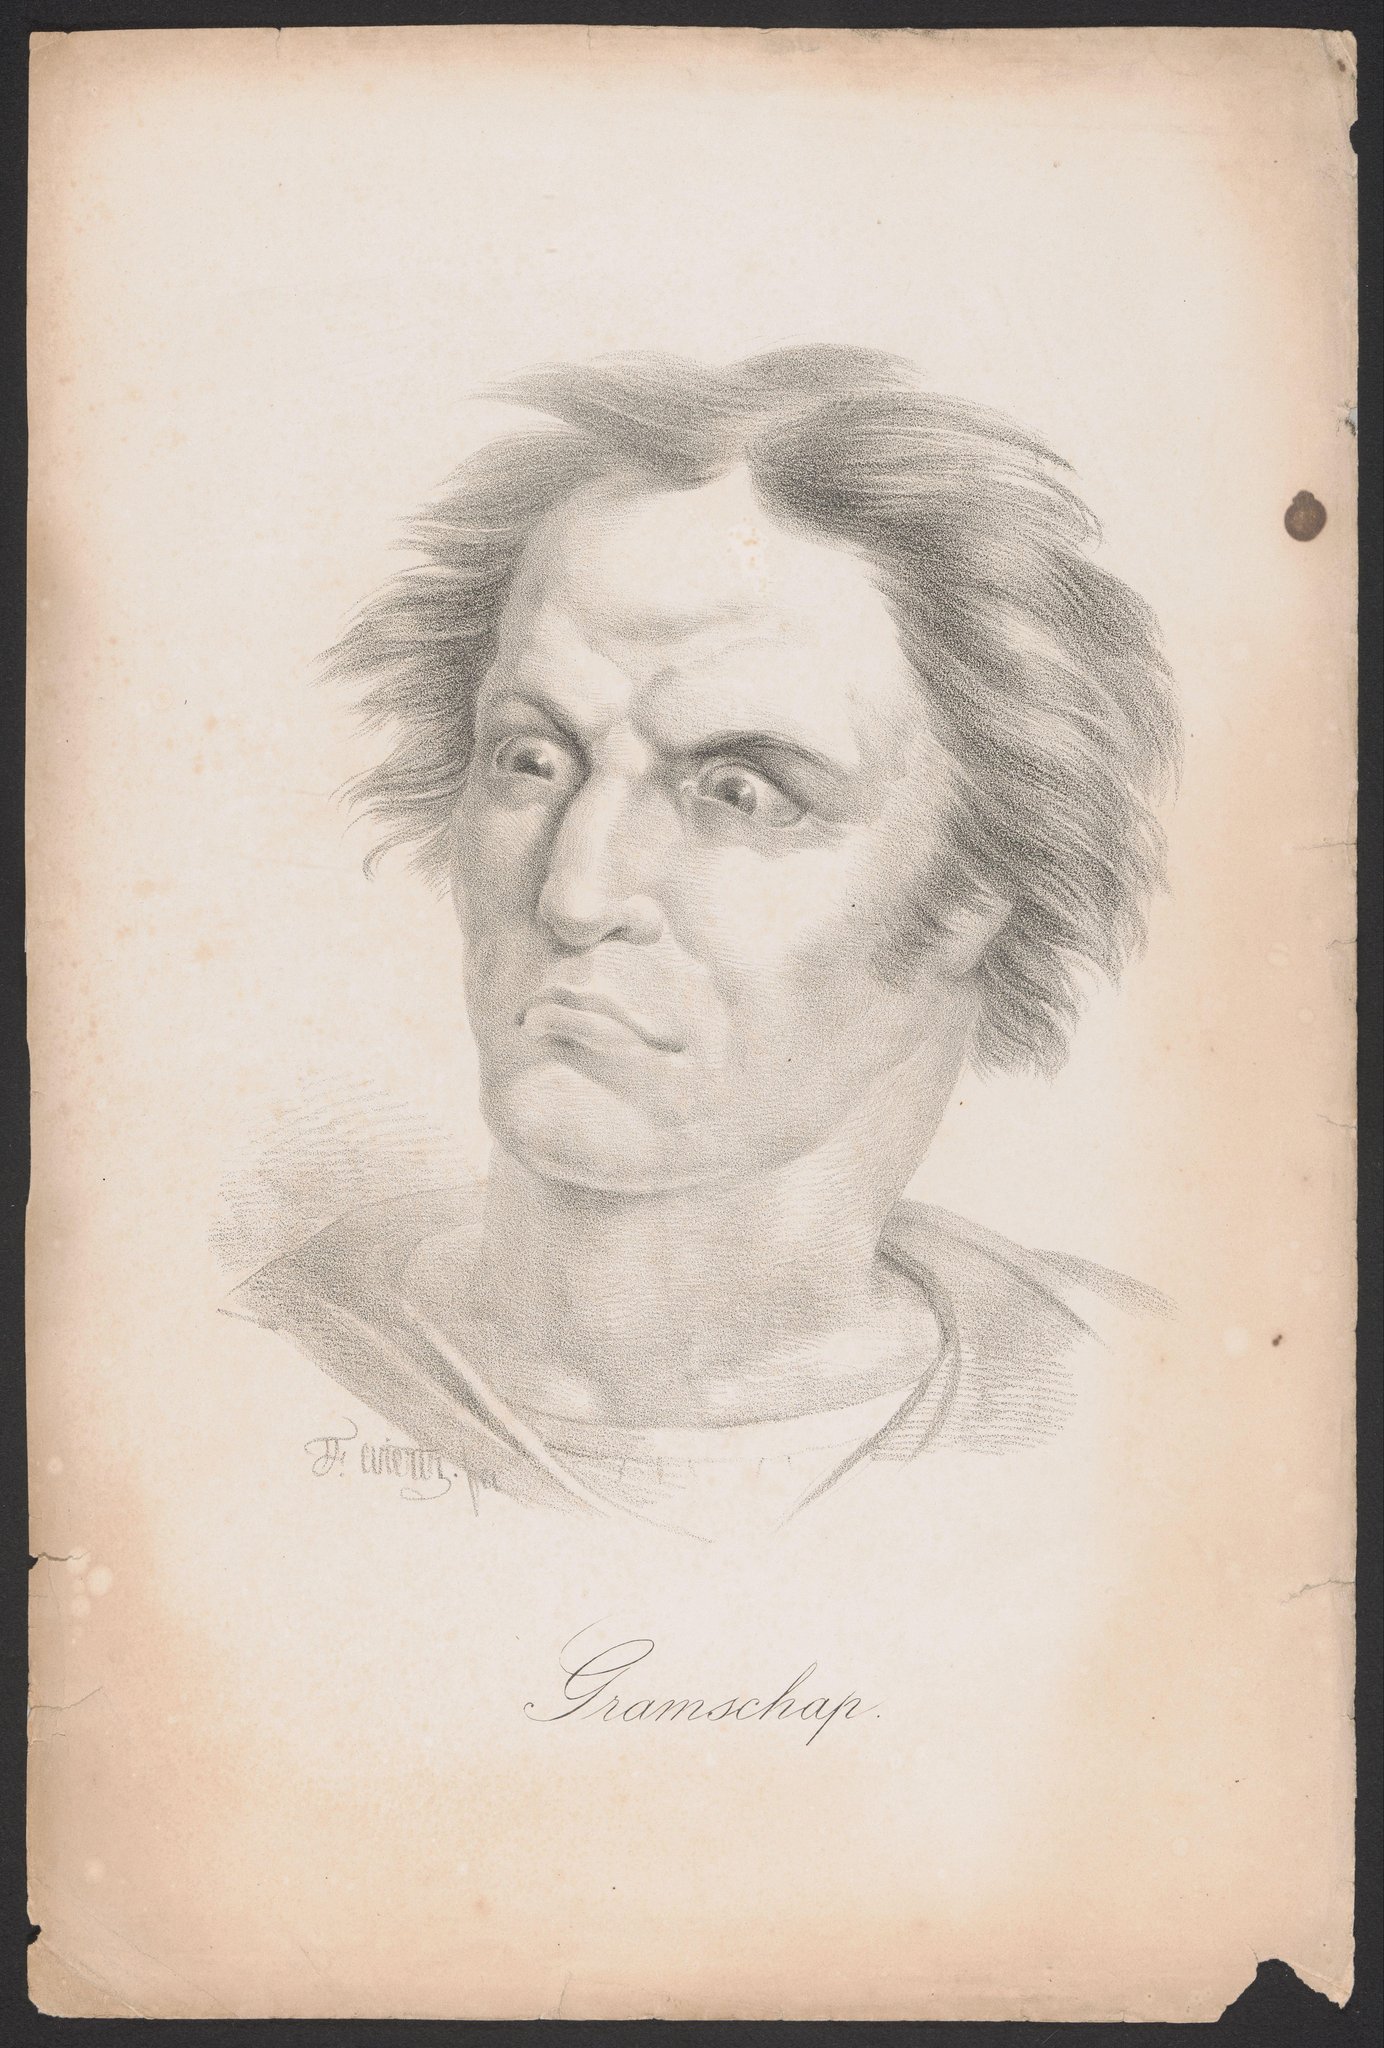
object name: print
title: Twaalf voorstellingen van hartstogten, tevens geschikt voor studiën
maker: henricus franciscus wiertz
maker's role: draughtsman, painter, print maker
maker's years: 1784-1858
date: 1847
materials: paper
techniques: lithograph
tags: historical persons (+ head (and shoulders) (portrait)), passions, emotions, affections, rage, anger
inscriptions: collector's mark: Lugt 2228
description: Maakt deel uit van een omslag met een tekstblad en twaalf prenten.